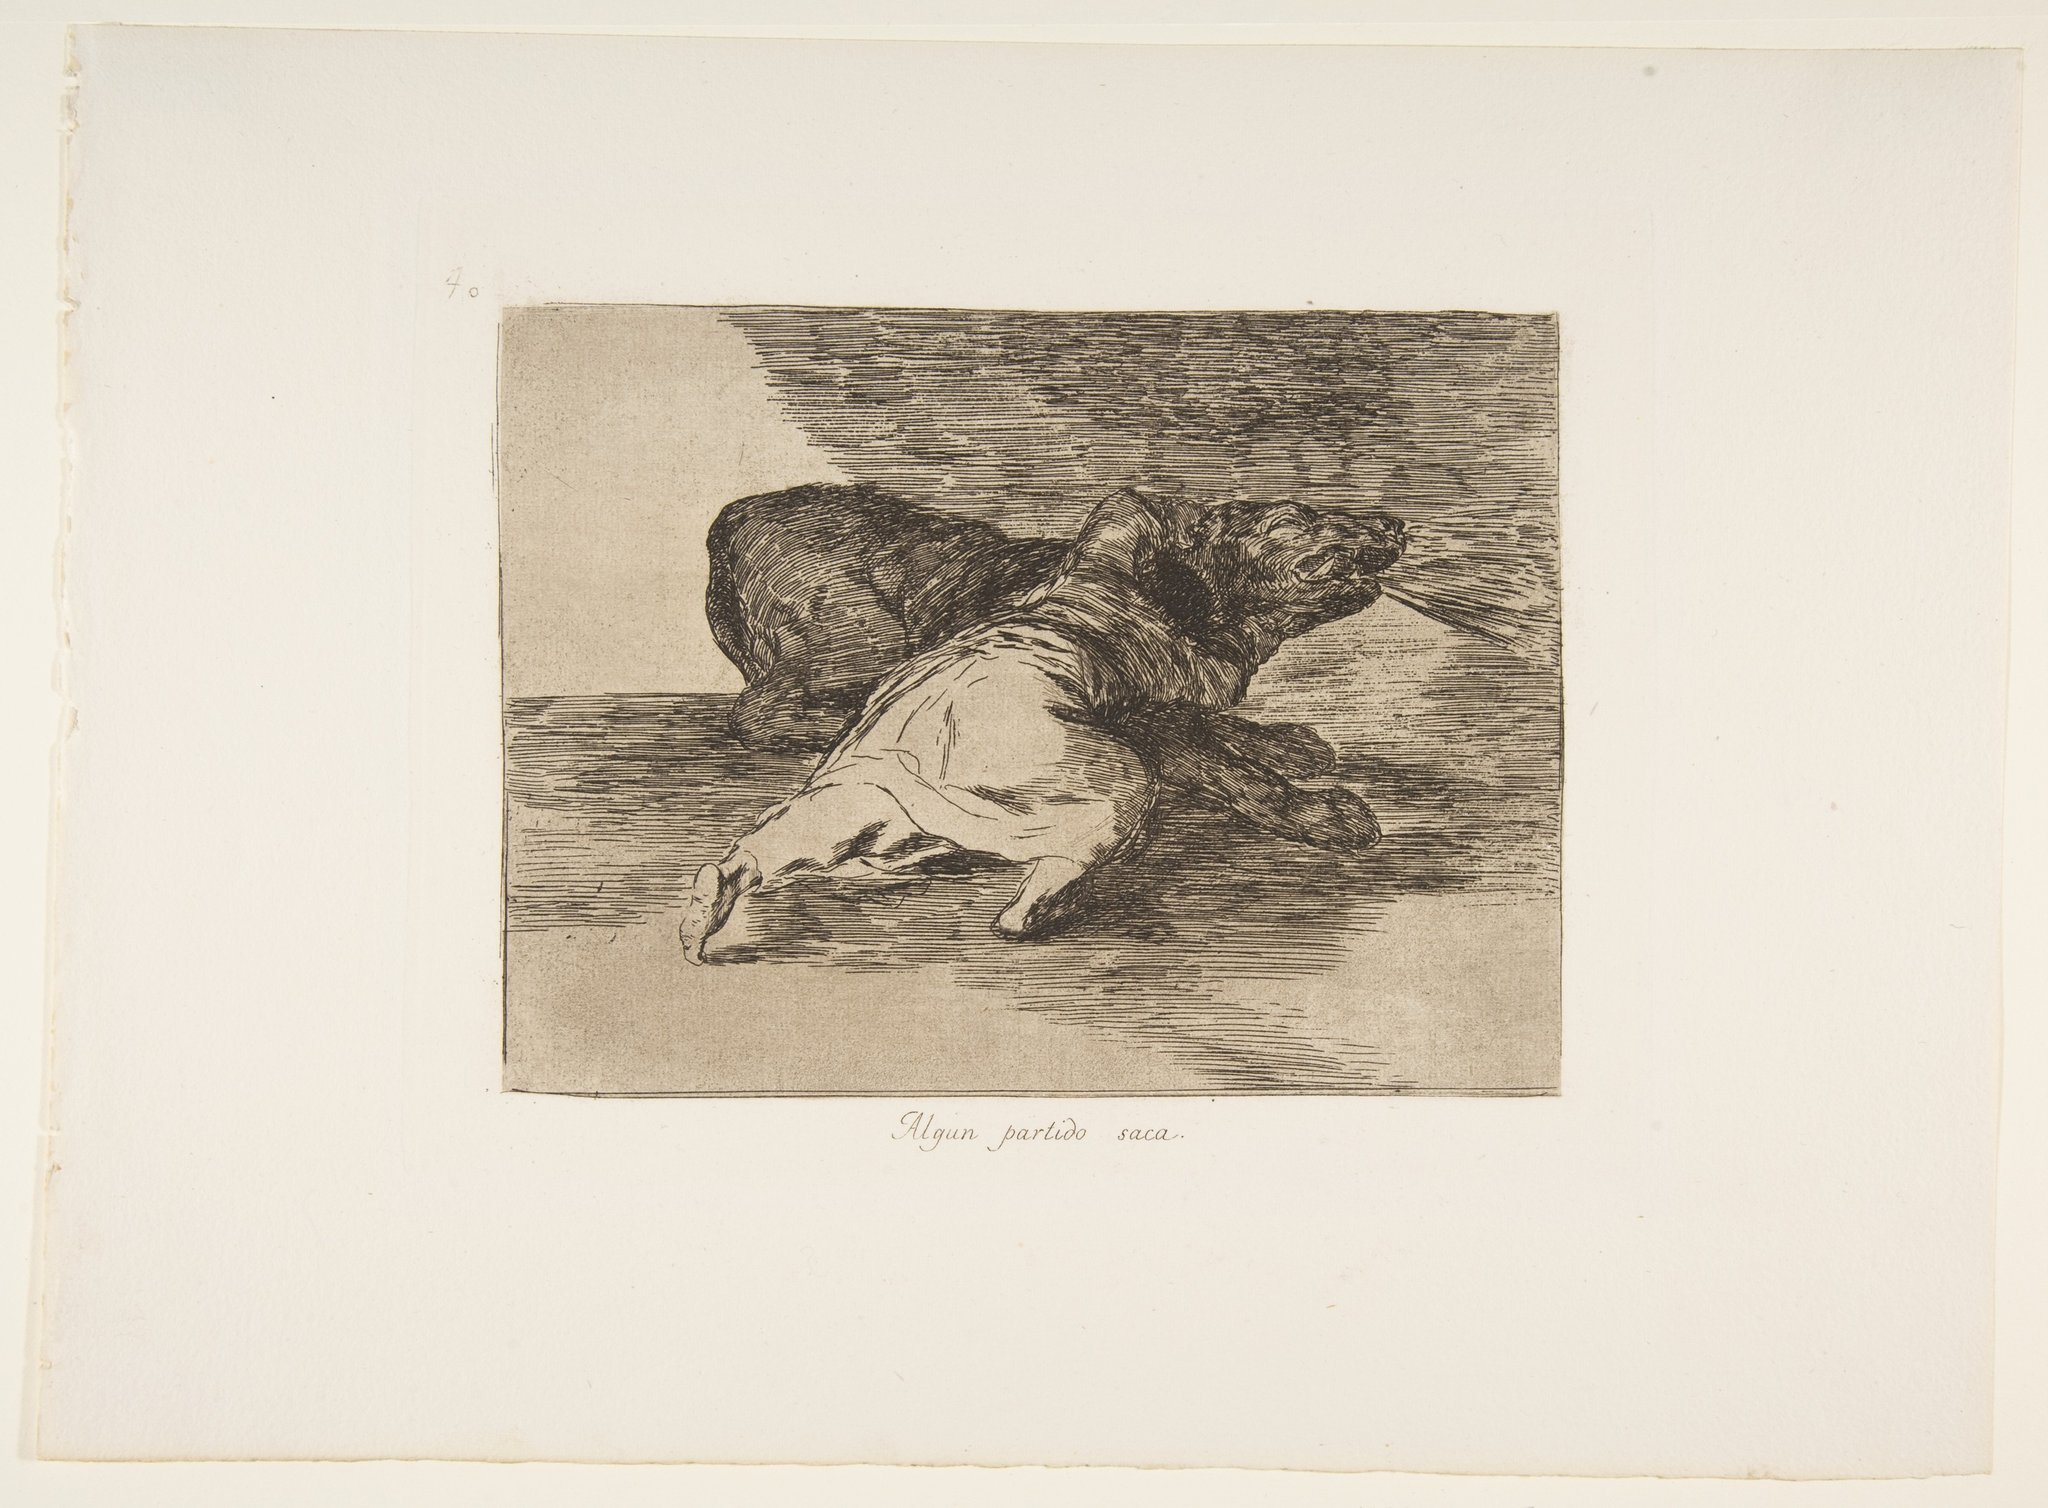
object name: print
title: Plate 40 from "The Disasters of War" (Los Desastres de La Guerra): 'He gets something out of it' (Algun partido saca)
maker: goya (francisco de goya y lucientes)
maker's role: artist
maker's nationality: spanish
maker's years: 1746-1828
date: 1810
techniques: engraving, drypoint, etching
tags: suffering,men